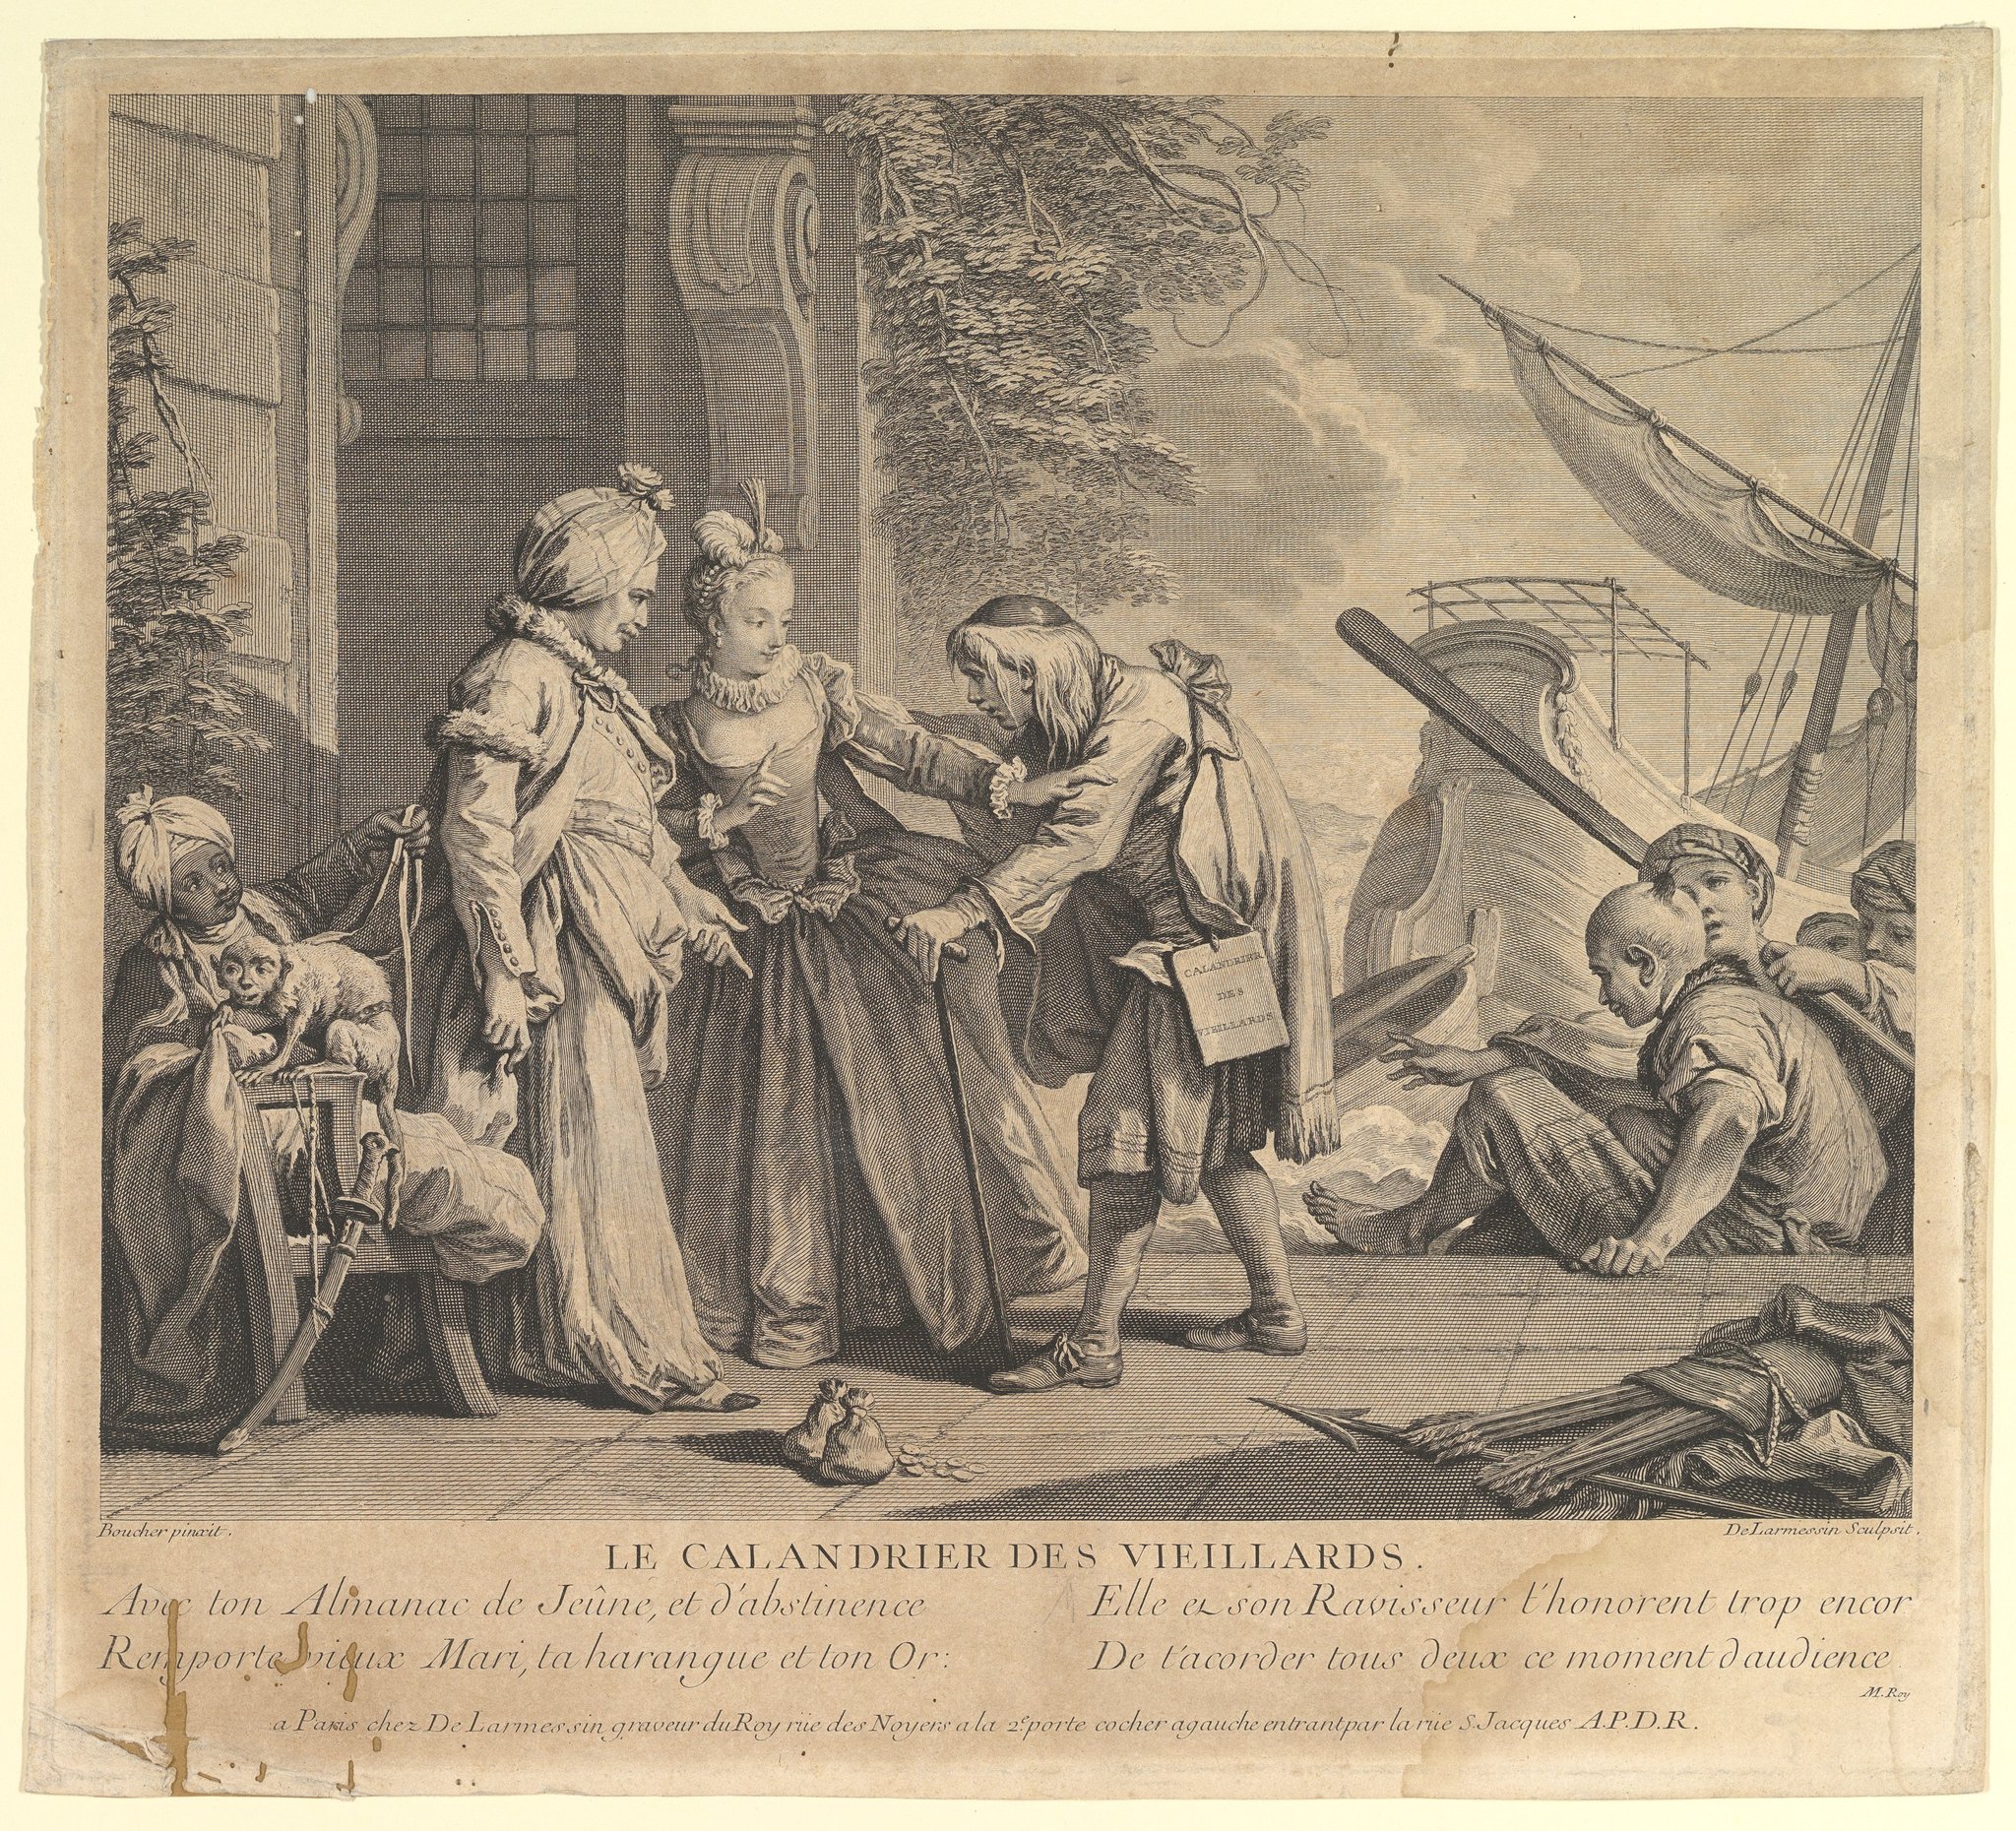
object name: print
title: Le Calandrier des Vieillards (The Calendar of Old Men, from Suite d'Estampes Nouvelles pour les Contes de la Fontaine (Series of New Prints for the Tales of La Fontaine)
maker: nicolas de larmessin iii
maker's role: artist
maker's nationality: french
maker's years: 1685-1755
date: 1701-1800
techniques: engraving, etching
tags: boys,men,women,monkeys